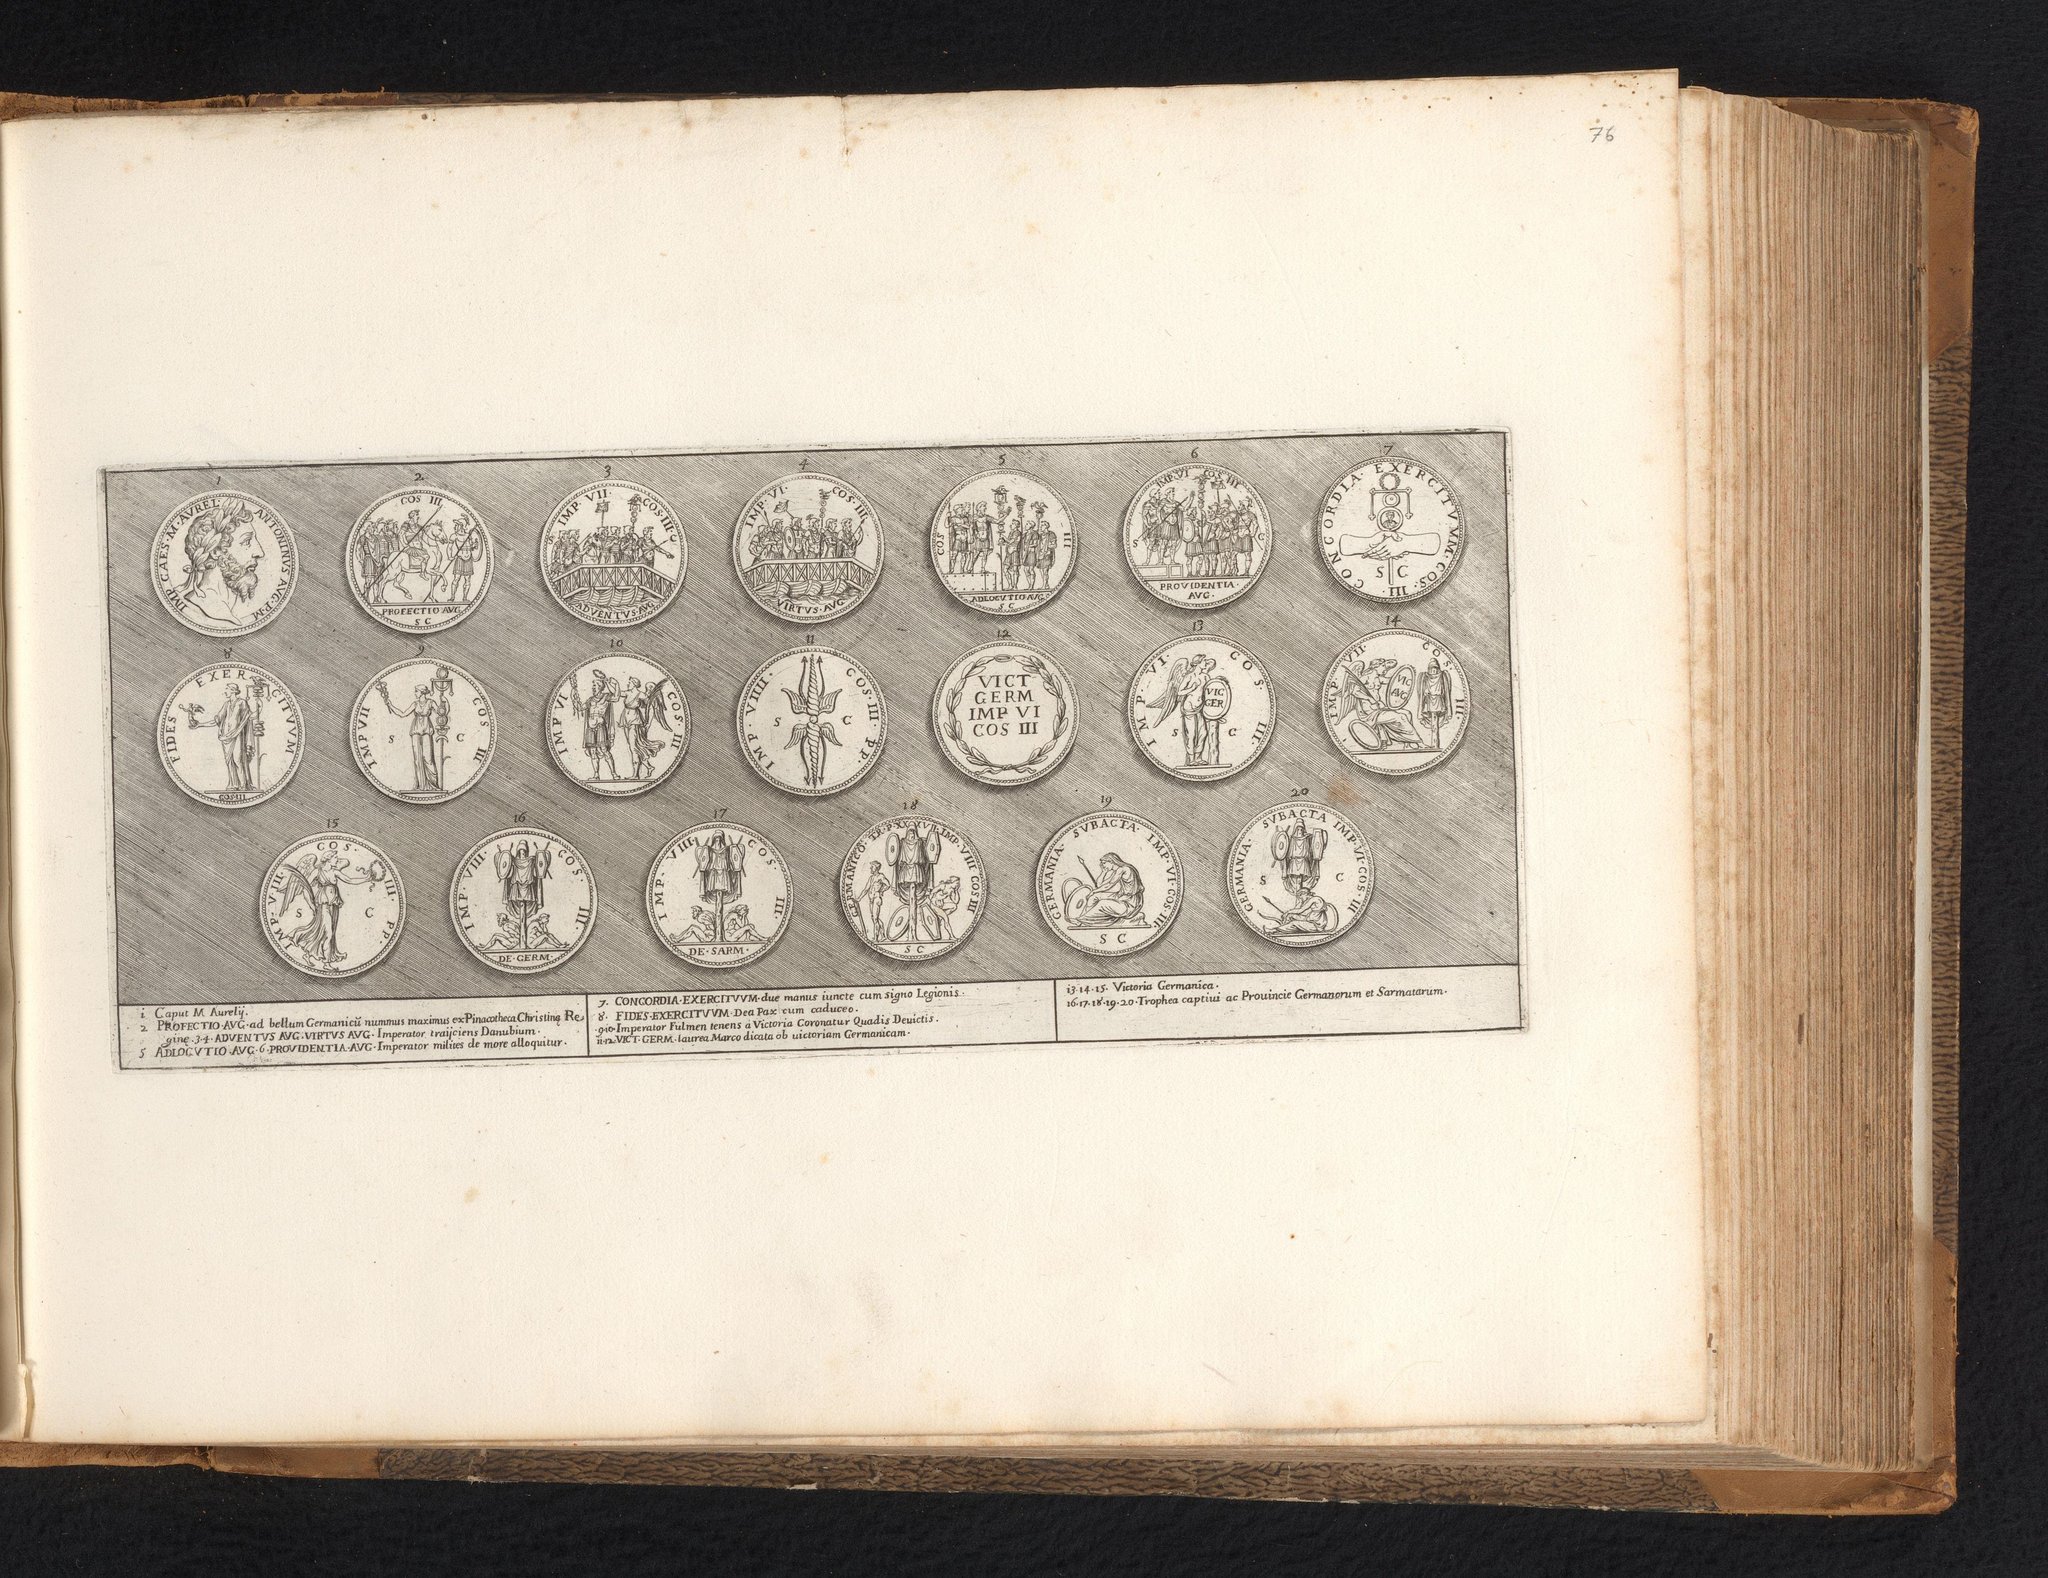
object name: album leaf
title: Twintig munten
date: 1672-1675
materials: paper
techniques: etching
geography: rome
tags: coin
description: Twintig munten uitgegeven tijdens en na de oprichting van de Zuil van Marcus Aurelius. Een lijst met verklarende nummers in de ondermarge. Prent maakt deel uit van een album.